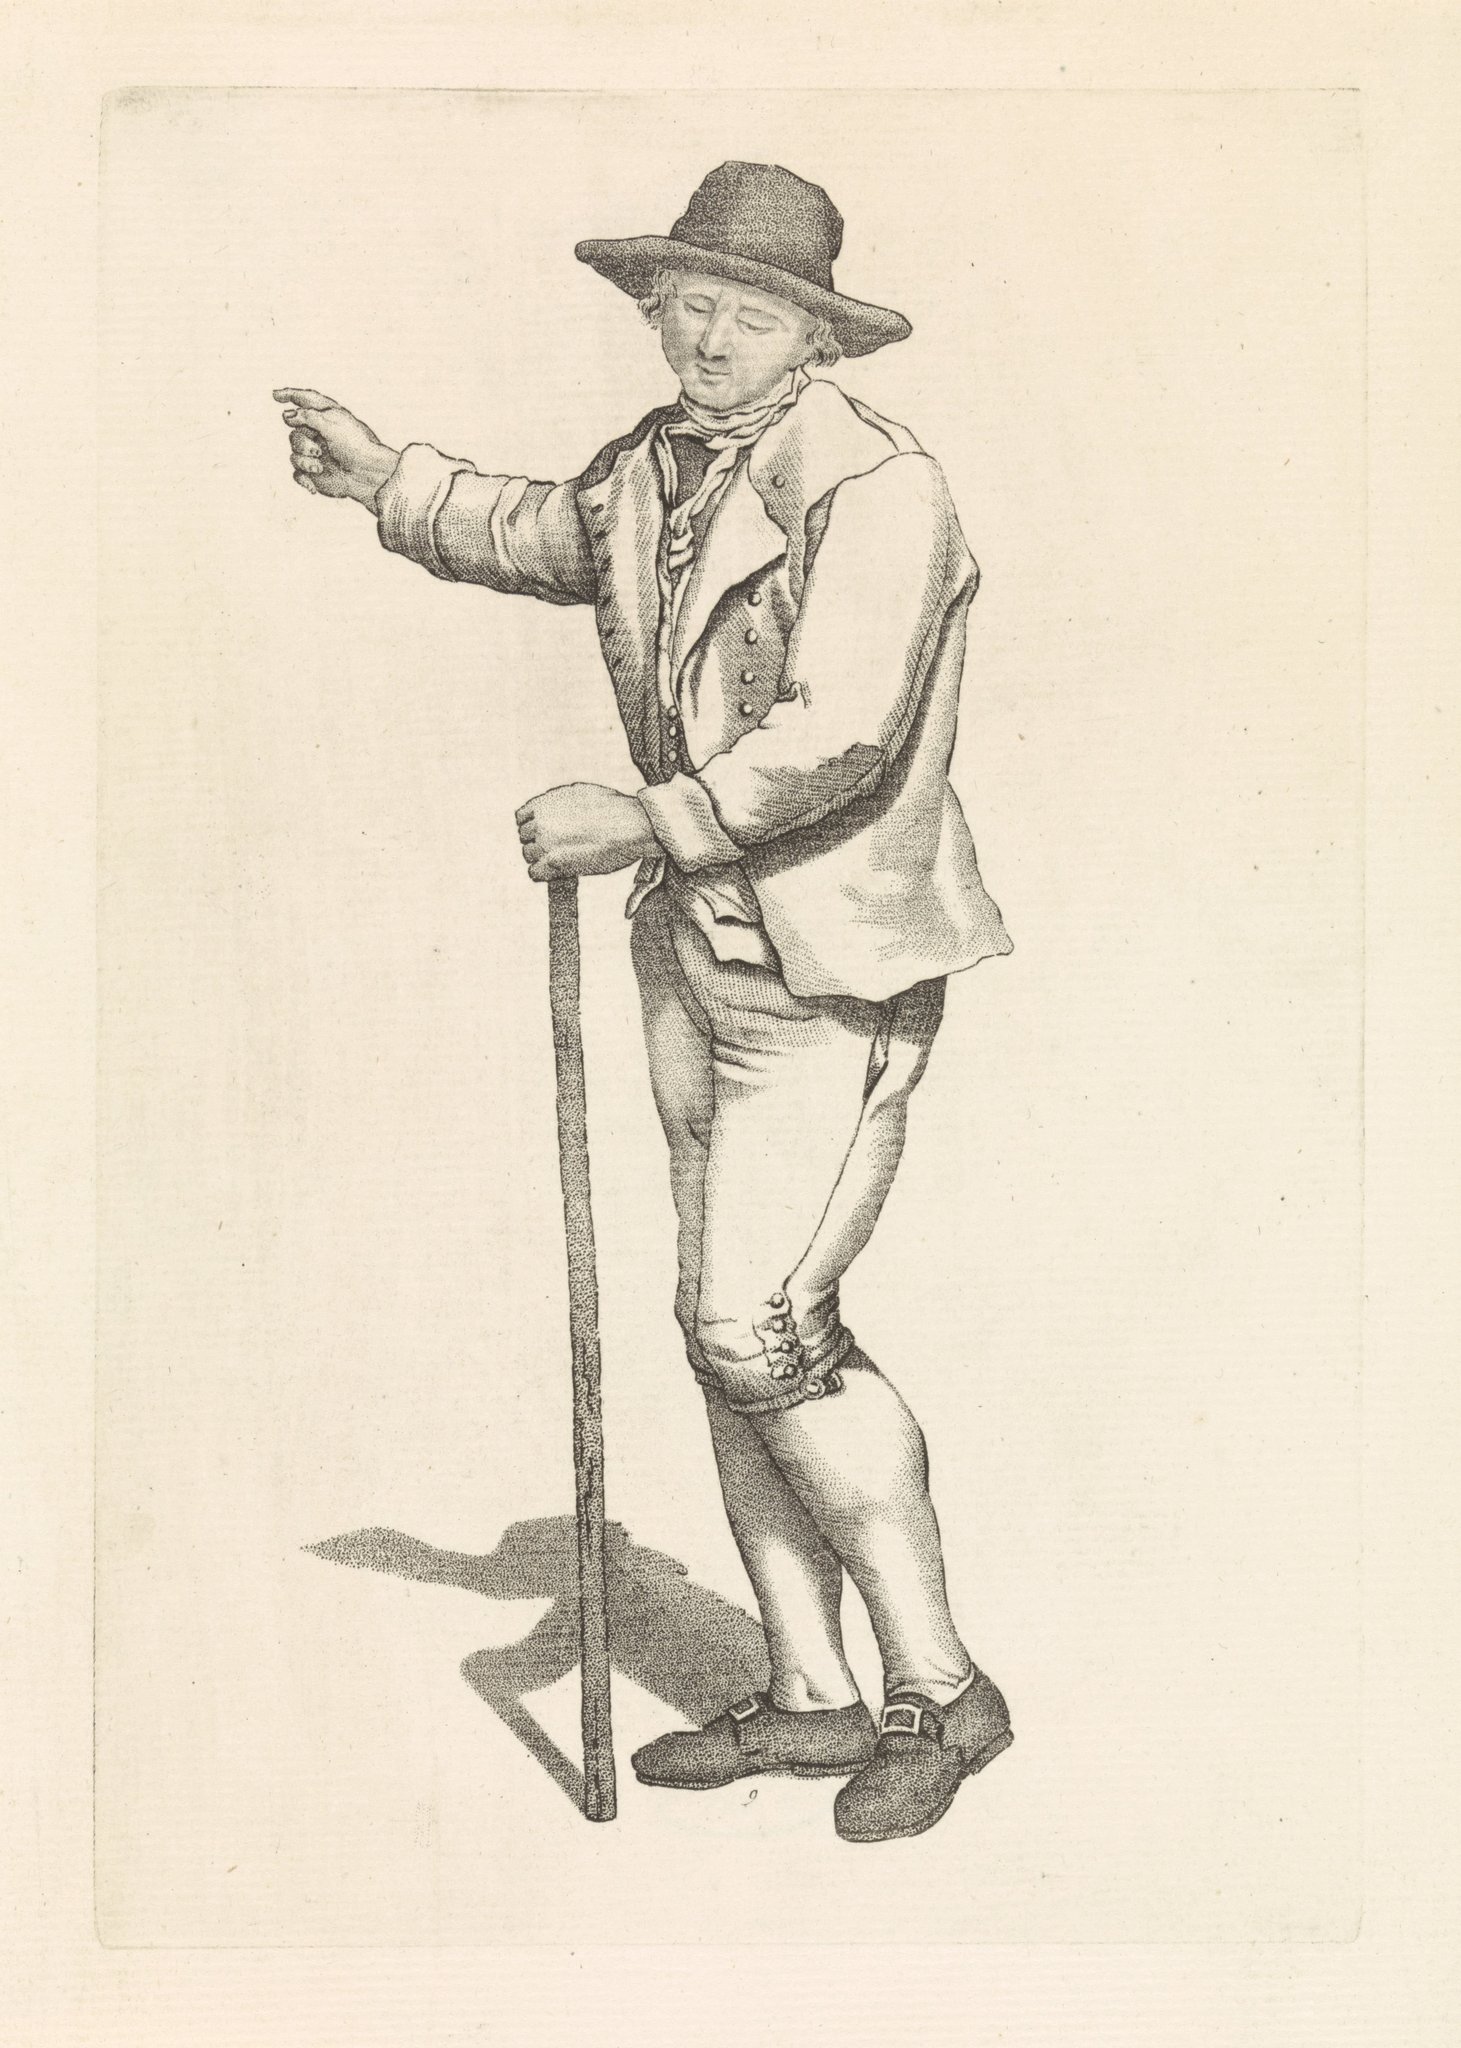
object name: print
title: Blinde man met stok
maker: mathias de sallieth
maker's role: print maker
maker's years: 1749-1791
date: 1772-1791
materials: paper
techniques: printmaking, etching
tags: blind, blindness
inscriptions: collector's mark: Lugt 2228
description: De prent verscheen vanaf 1818 tevens als onderdeel van een 33-delige reeks prenten door Mathias de Sallieth, samengebonden in: Perkois, Jacobus, Prins, Johannes Huibert. Verzameling van verschillende gekleede mans- en vrouwenstanden, ter oefening van jonge schilders en liefhebbers. Rotterdam: Johannes Immerzeel, 1818.